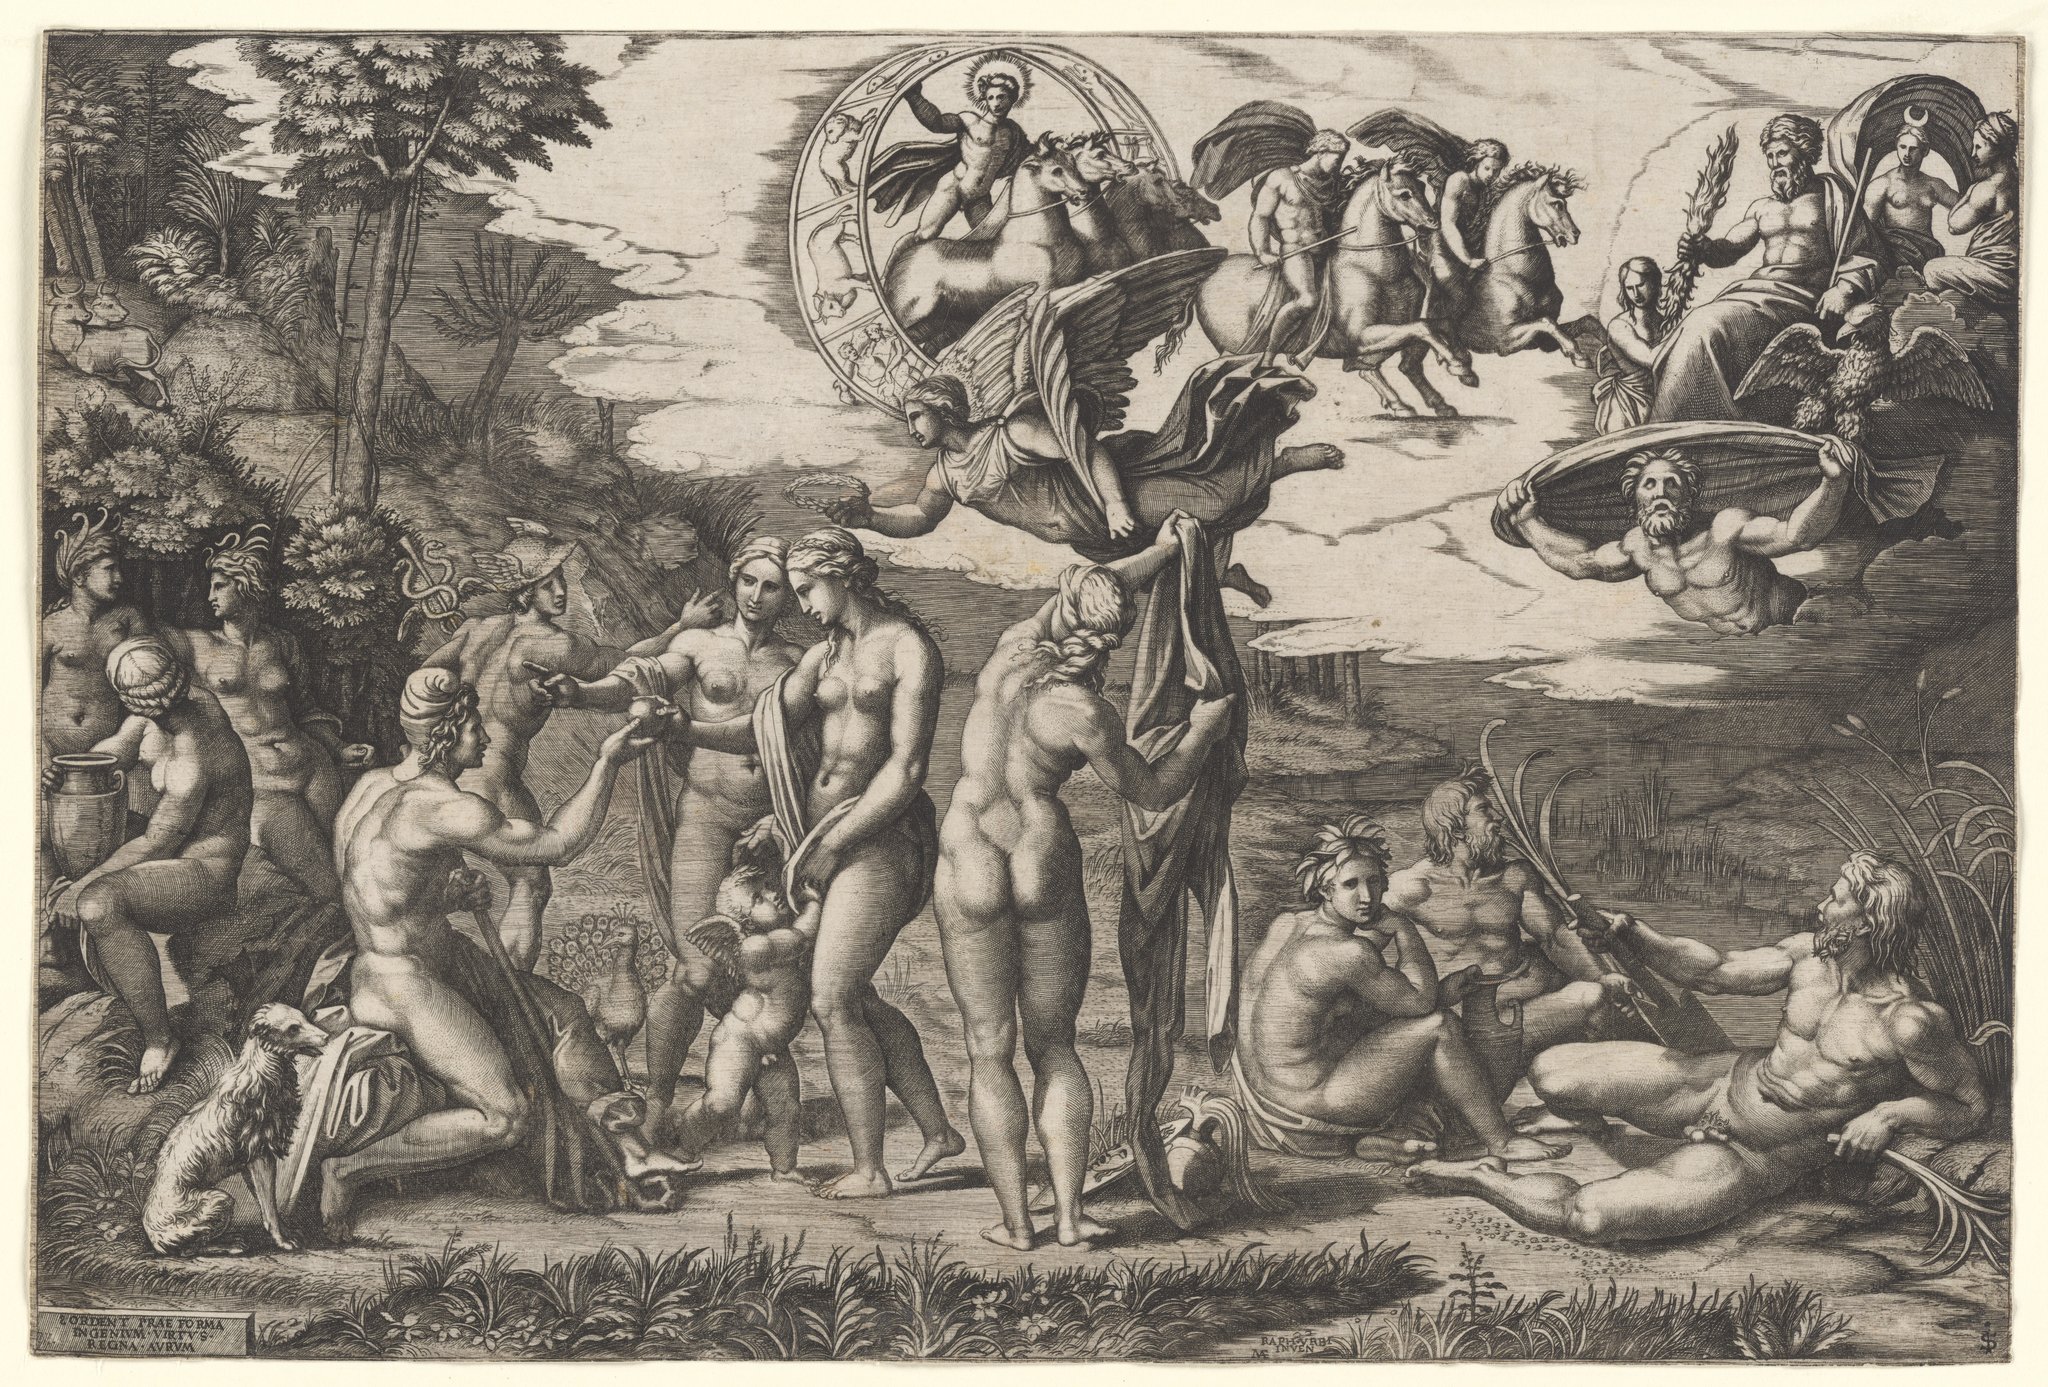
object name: print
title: The Judgment of Paris: he is sitting at left with Venus, Juno and Pallas Athena, a winged victory above. In the upper section the Sun in his chariot preceeded by Castor and Pollux on horseback, at lower right two river gods and a naiad above whom Jupiter, an eagle, Ganymede, Diana and another goddess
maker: marcantonio raimondi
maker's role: artist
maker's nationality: italian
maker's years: 1475-1534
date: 1510-1520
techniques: engraving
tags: trojan war,athena,juno,venus,dogs,horses,goddess,chariots,paris